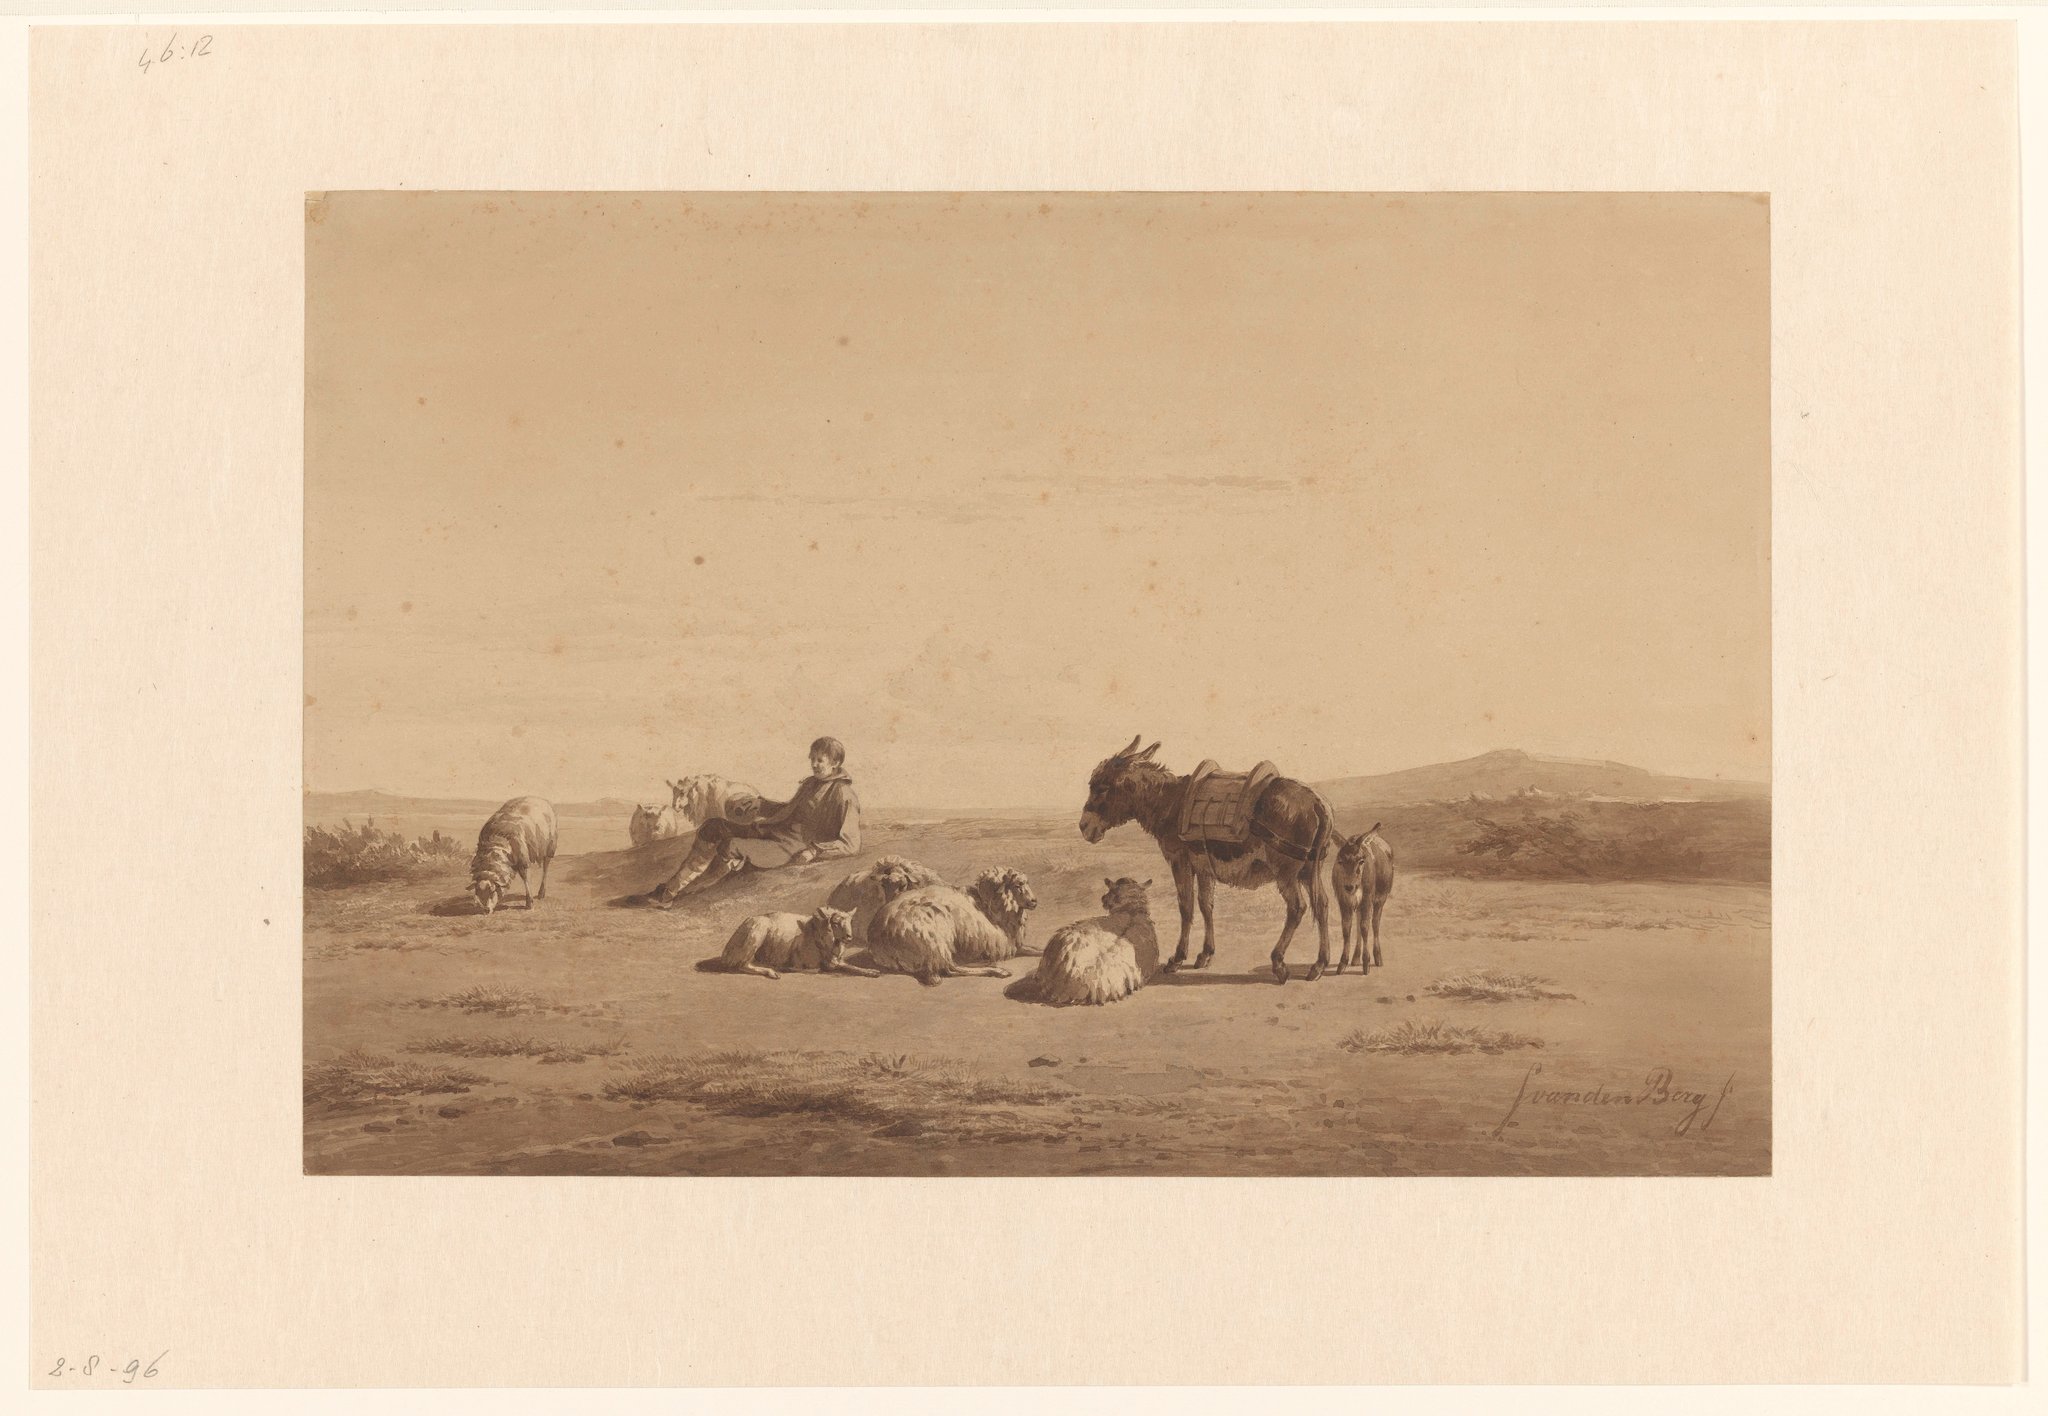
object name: drawing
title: Rustende schaapherder met ezel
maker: simon van den berg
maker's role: draughtsman, print maker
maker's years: 1812-1891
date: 1822-1891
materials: paper, pencil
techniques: brush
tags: ass, donkey